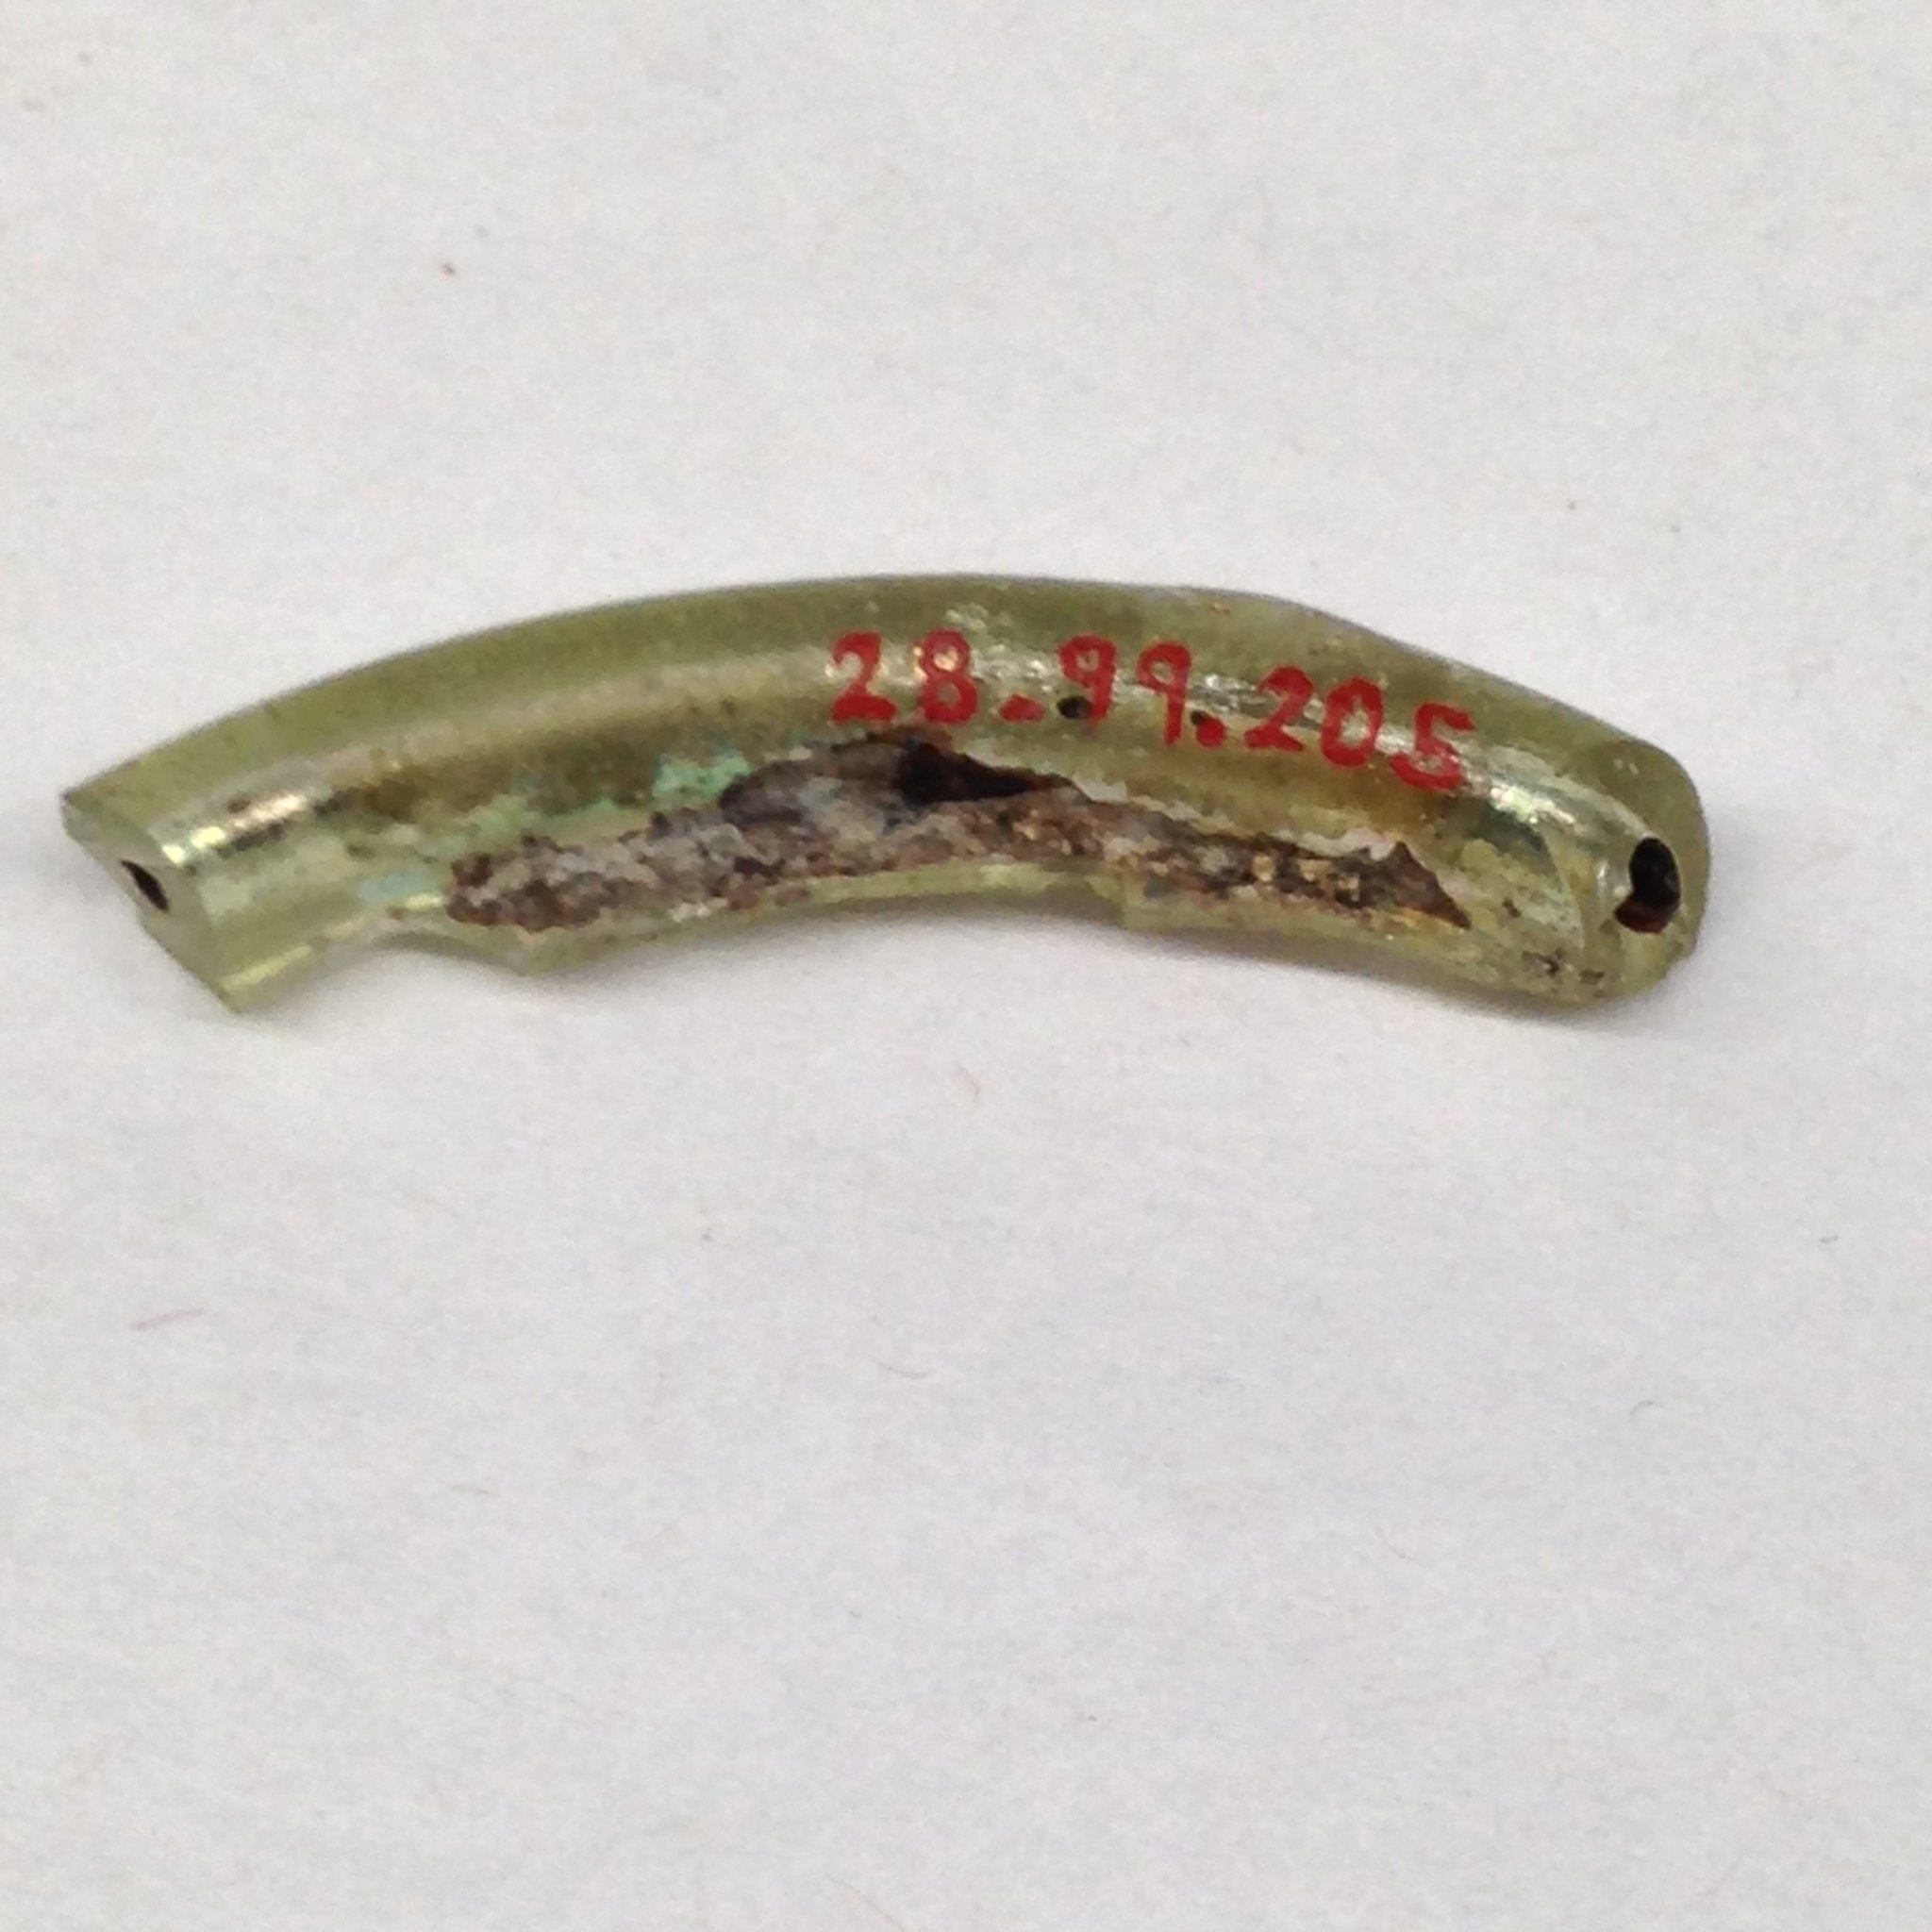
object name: fragment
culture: european or middle eastern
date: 1150-1250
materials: ceramic, glass